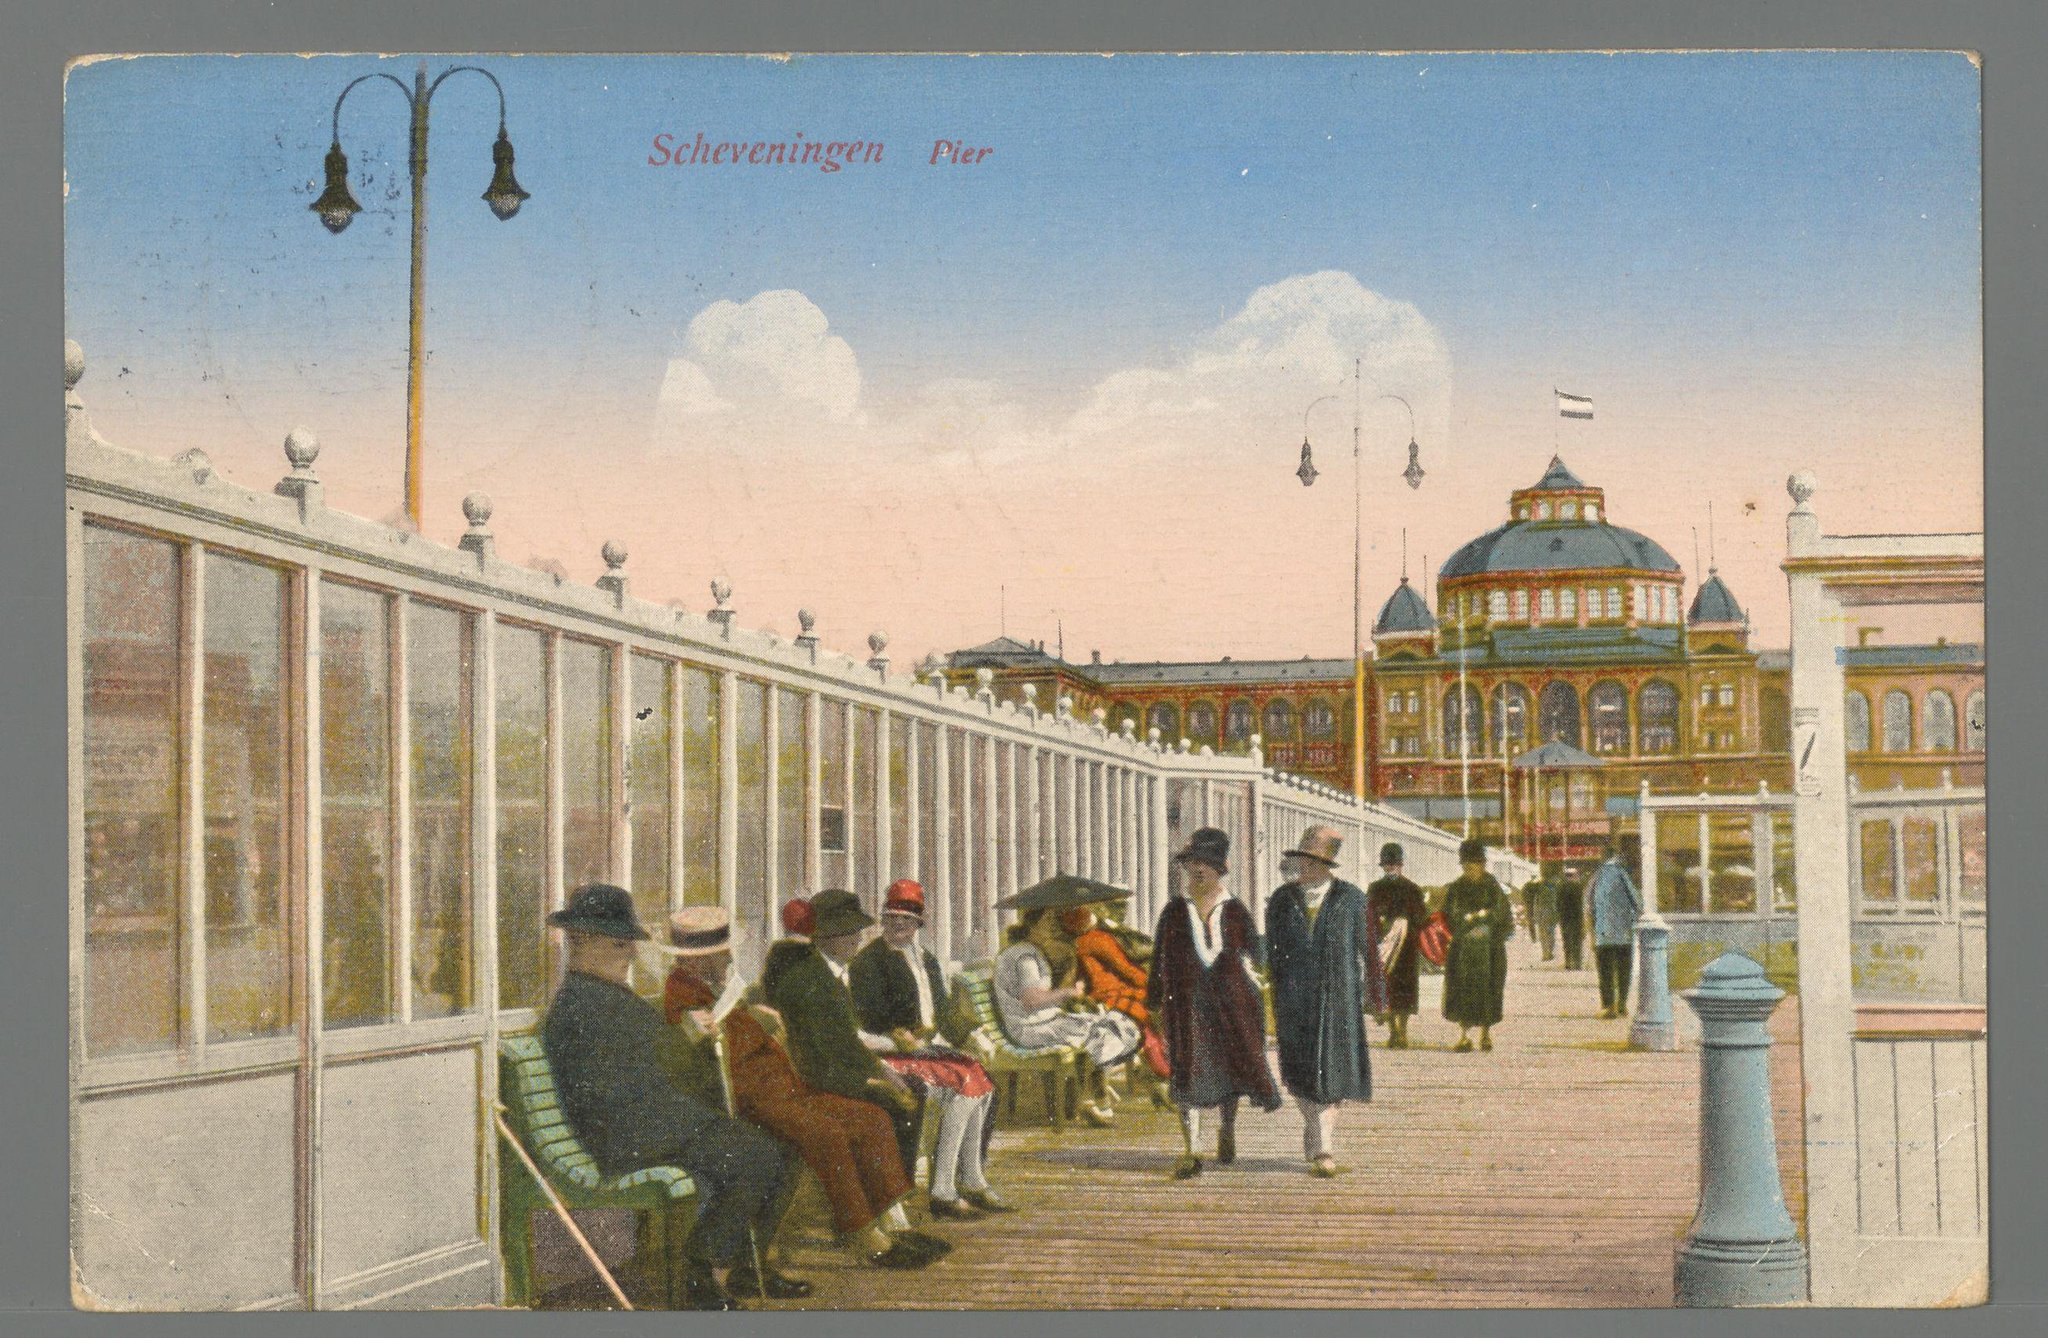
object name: ansichtkaart, prentbriefkaart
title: Scheveningen Pier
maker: Anonymous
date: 1905-1929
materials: cardboard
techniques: writing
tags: city-view in general; 'veduta', pier, quay, wharf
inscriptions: postage stamp